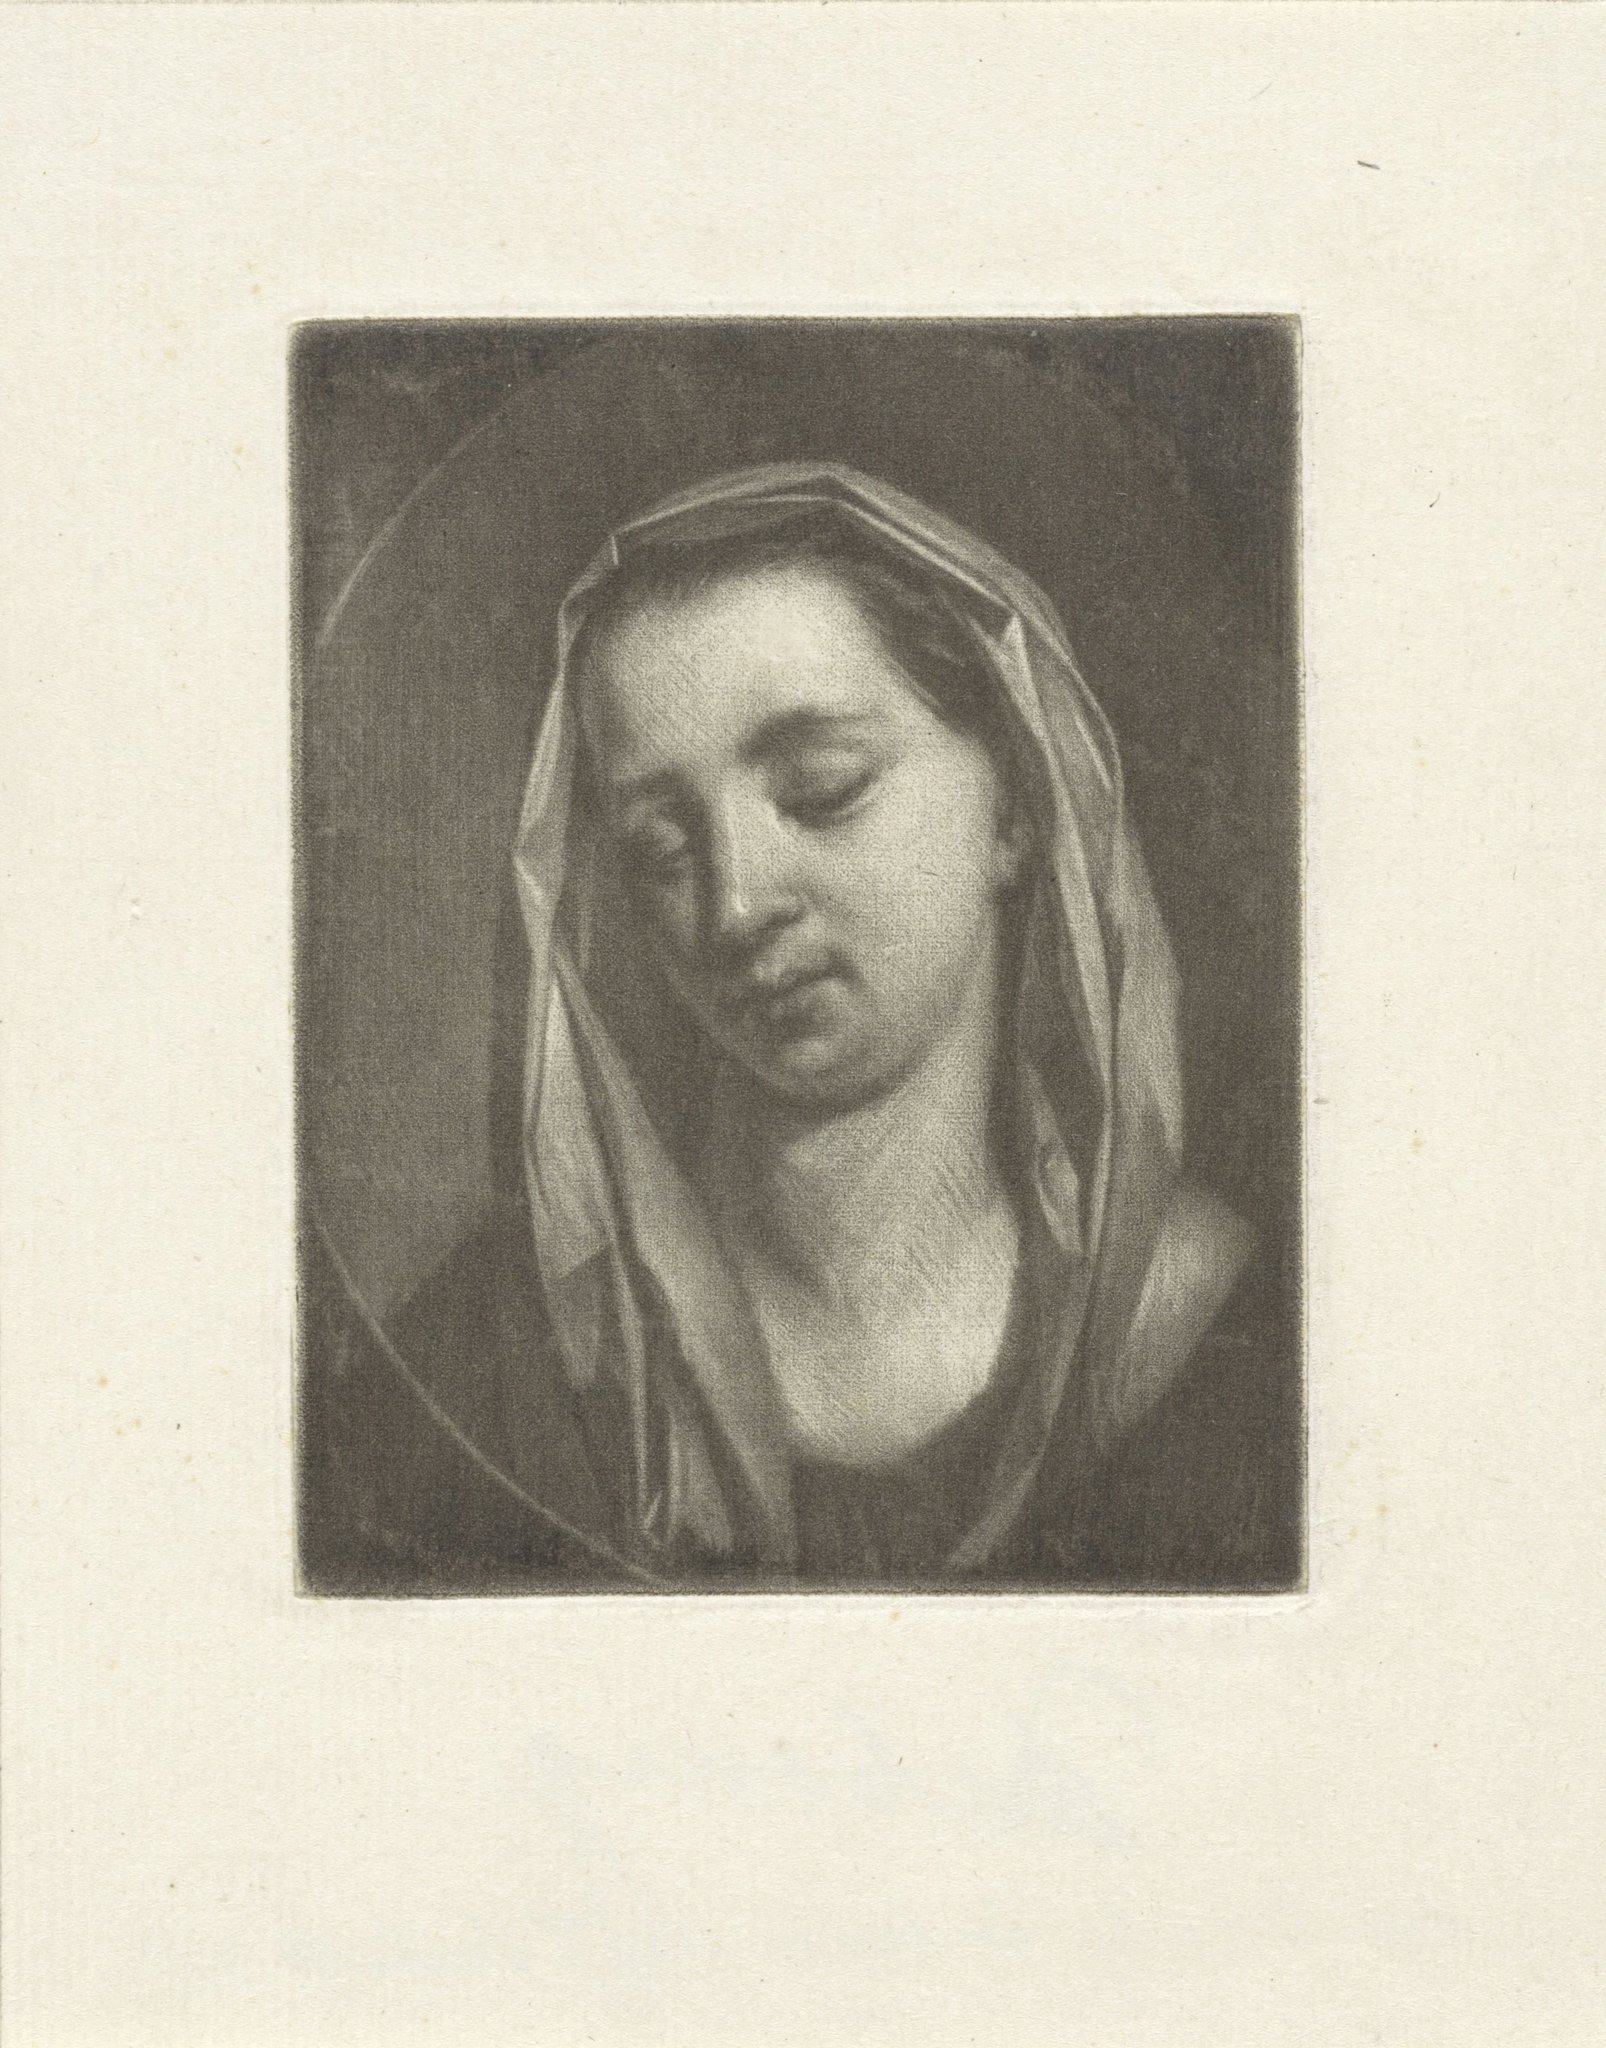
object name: print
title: Buste van Maria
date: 1660-1775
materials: paper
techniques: mezzotint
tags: 'portraits' of mary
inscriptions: collector's mark: Lugt 2228, collector's mark: Lugt 240